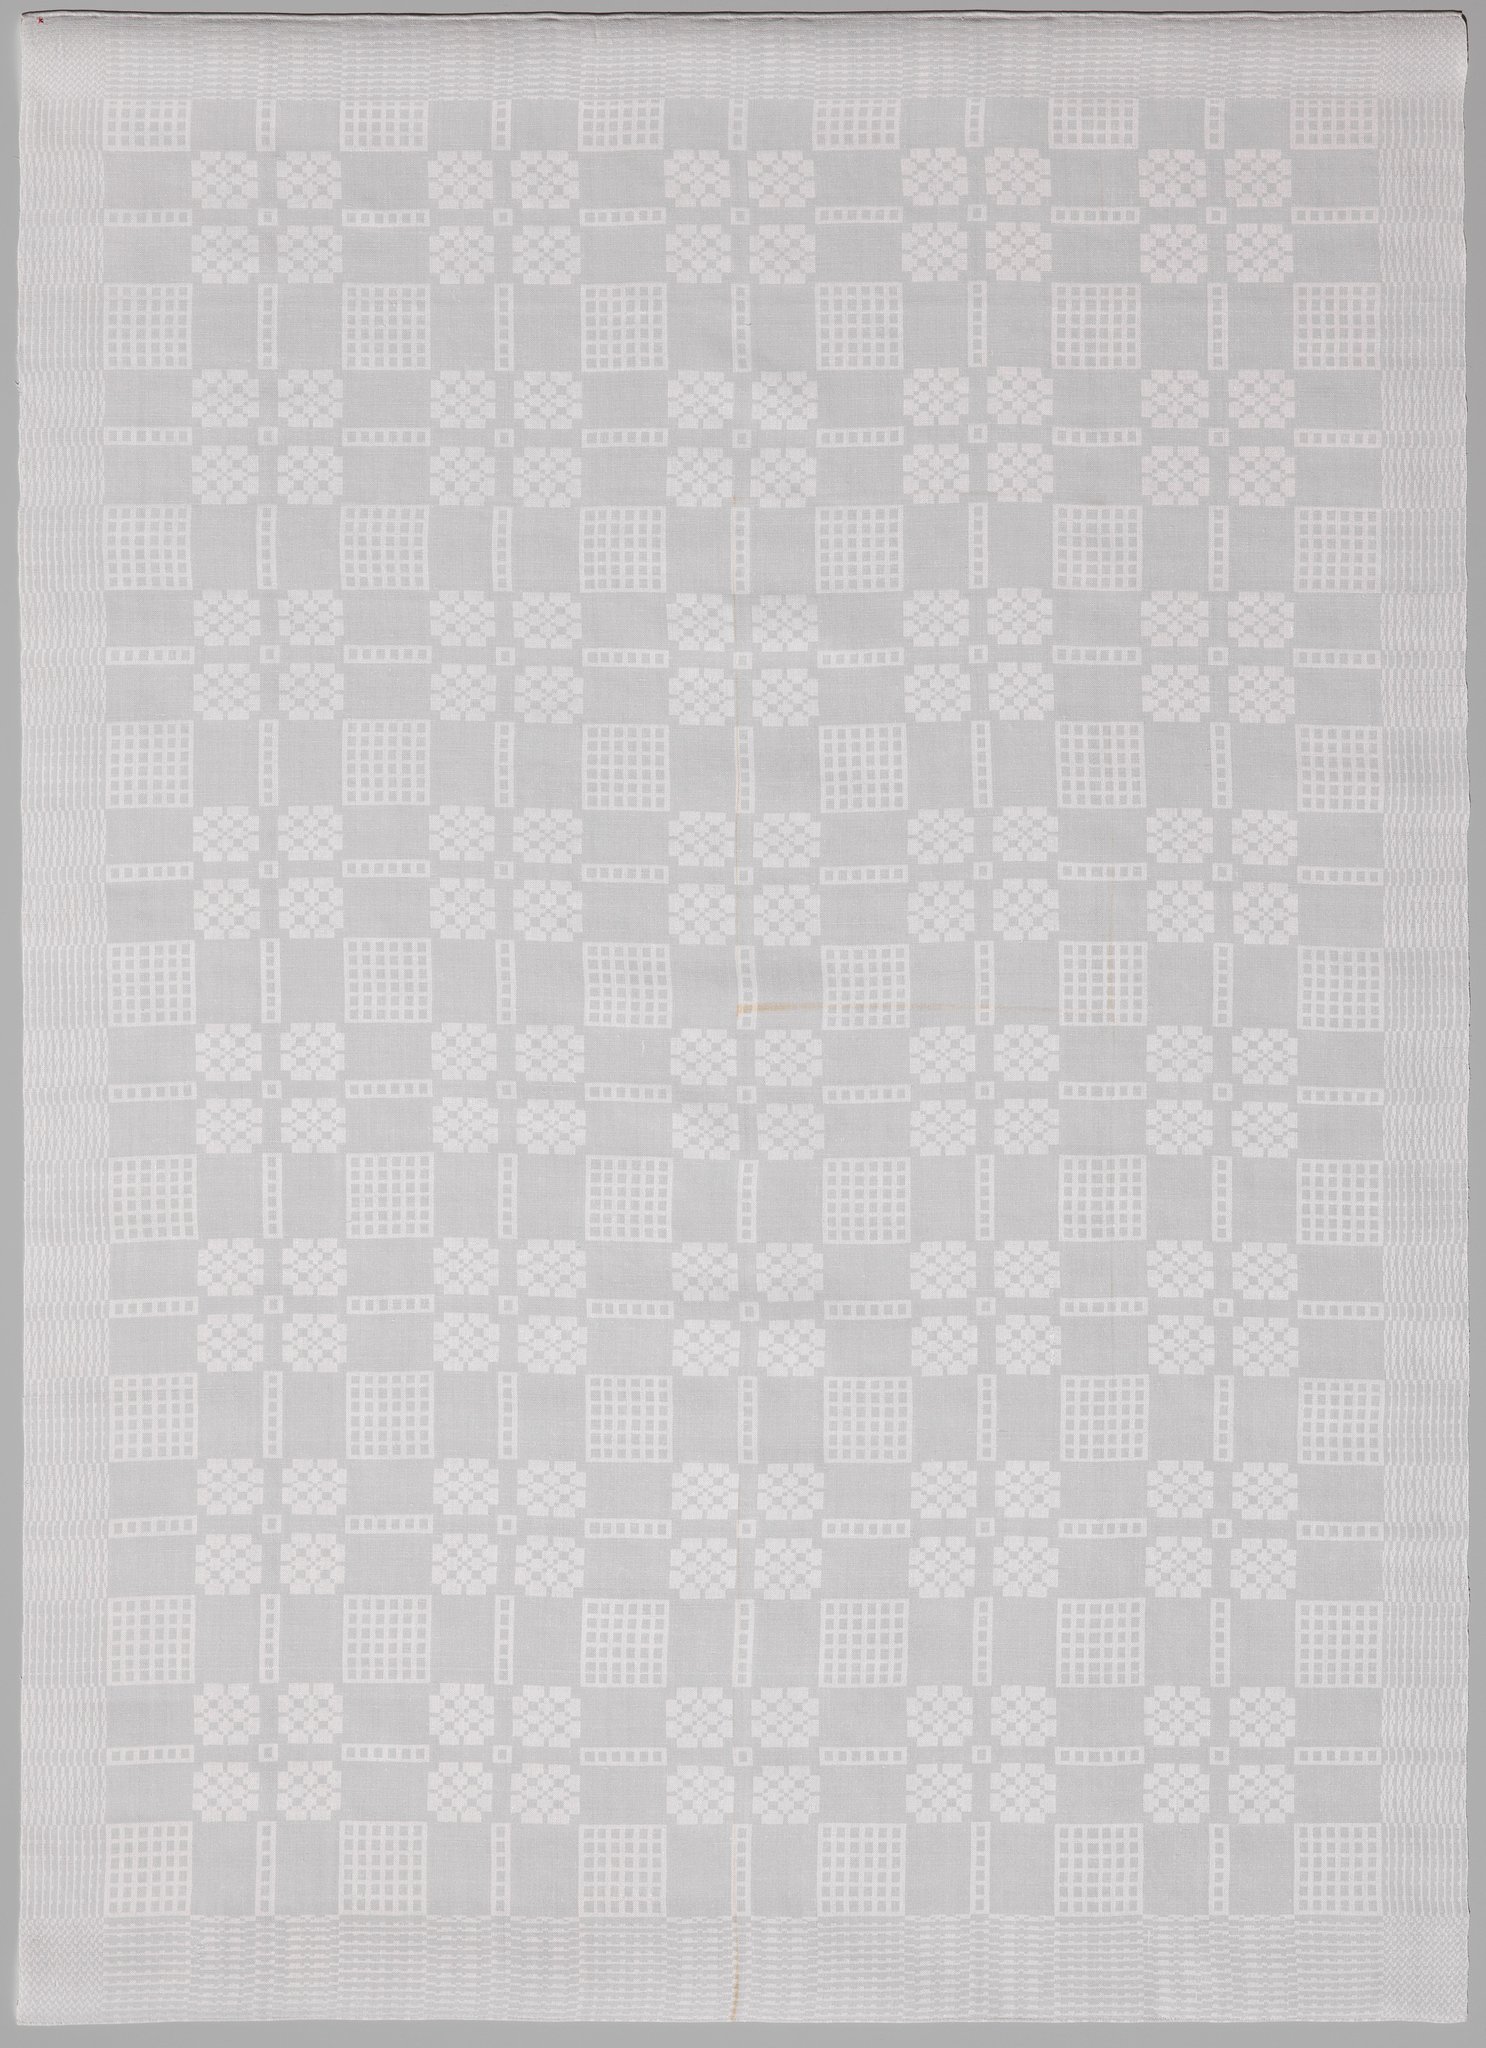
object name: napkin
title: Pellen: keper met wafelruit en bloemvorm. Merk: BS 48.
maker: Anonymous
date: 1675-1725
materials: linen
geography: northern netherlands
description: Servet van wit linnen met een pellen patroon in keper, een wafelruitje met een soort bloem, merk BS en 48.